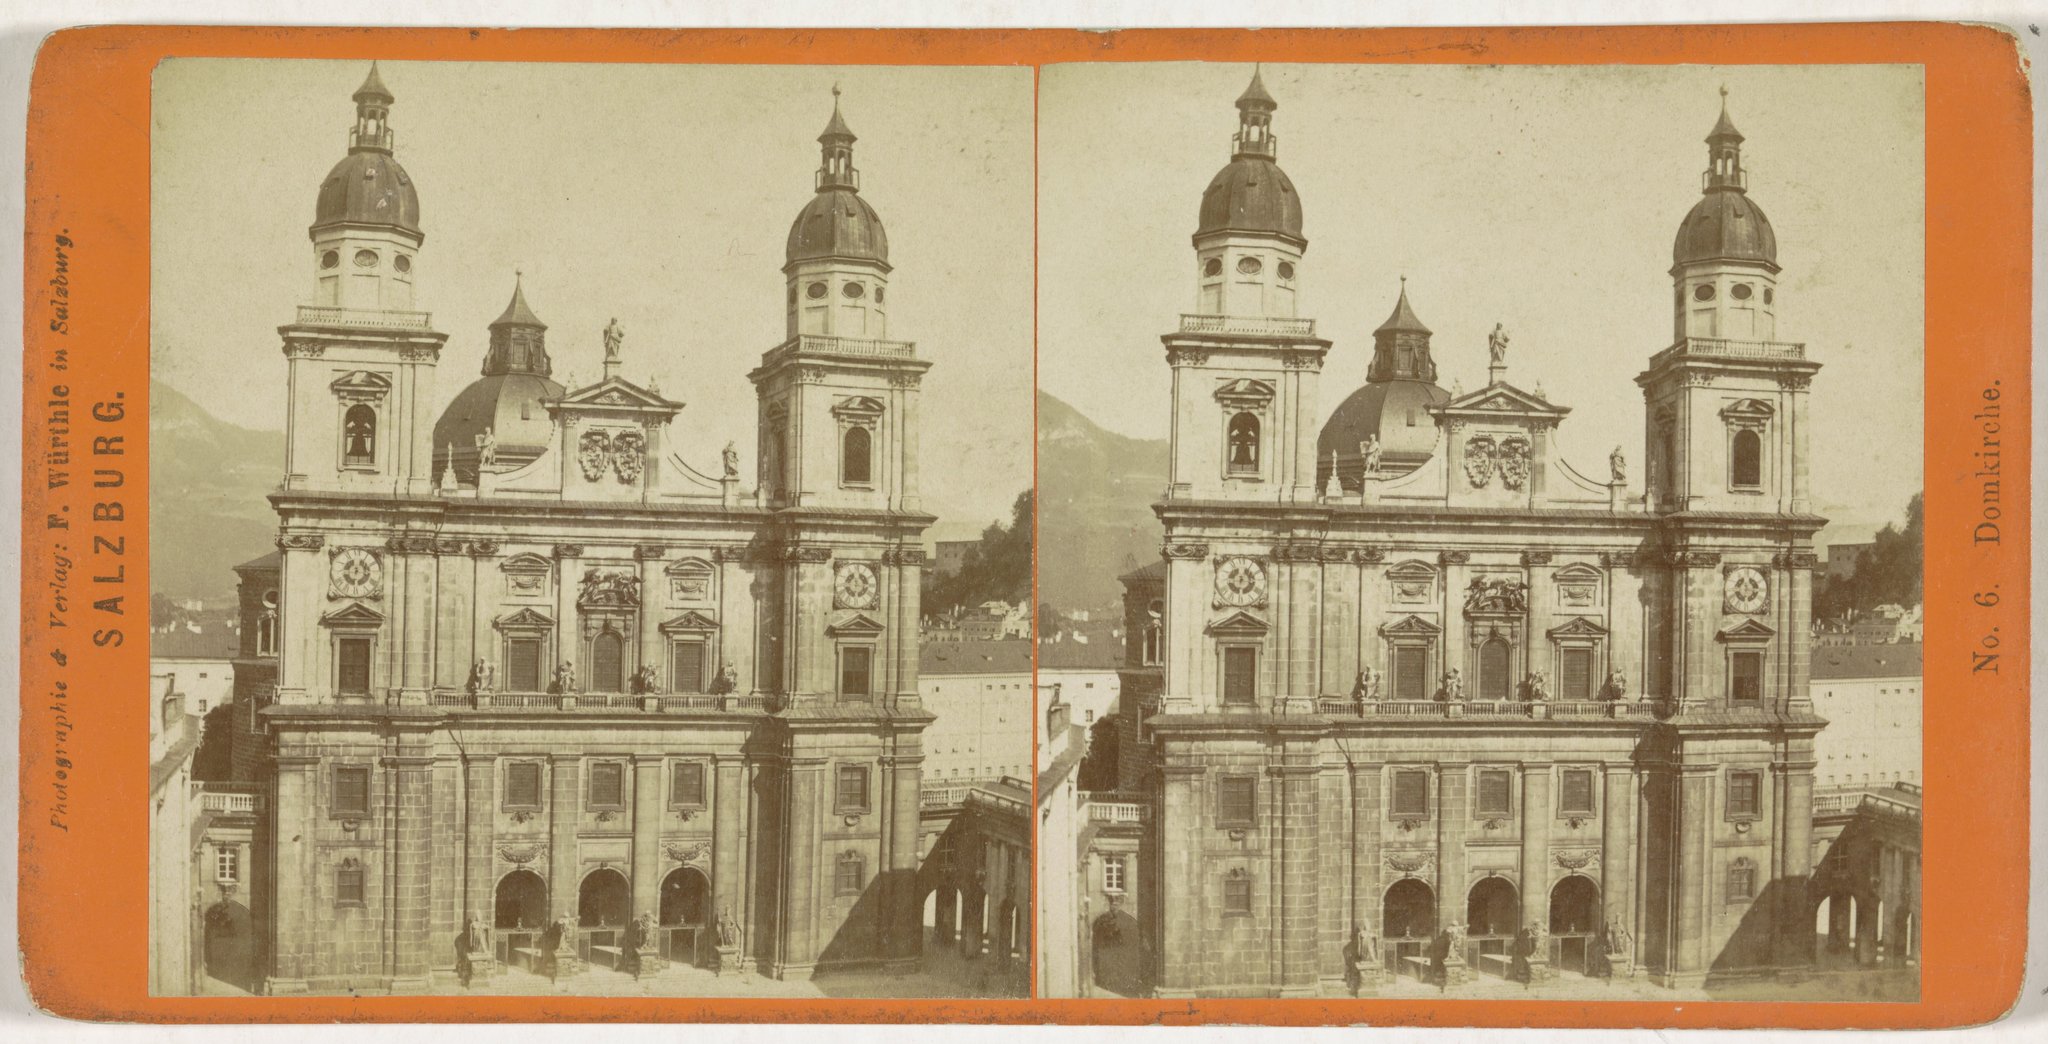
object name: stereograph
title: Salzburg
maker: carl friedrich würthle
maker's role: print maker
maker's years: 1820-1902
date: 1874-1875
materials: cardboard, paper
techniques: albumen print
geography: salzburg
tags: church (exterior)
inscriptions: number: ‘No. 6’